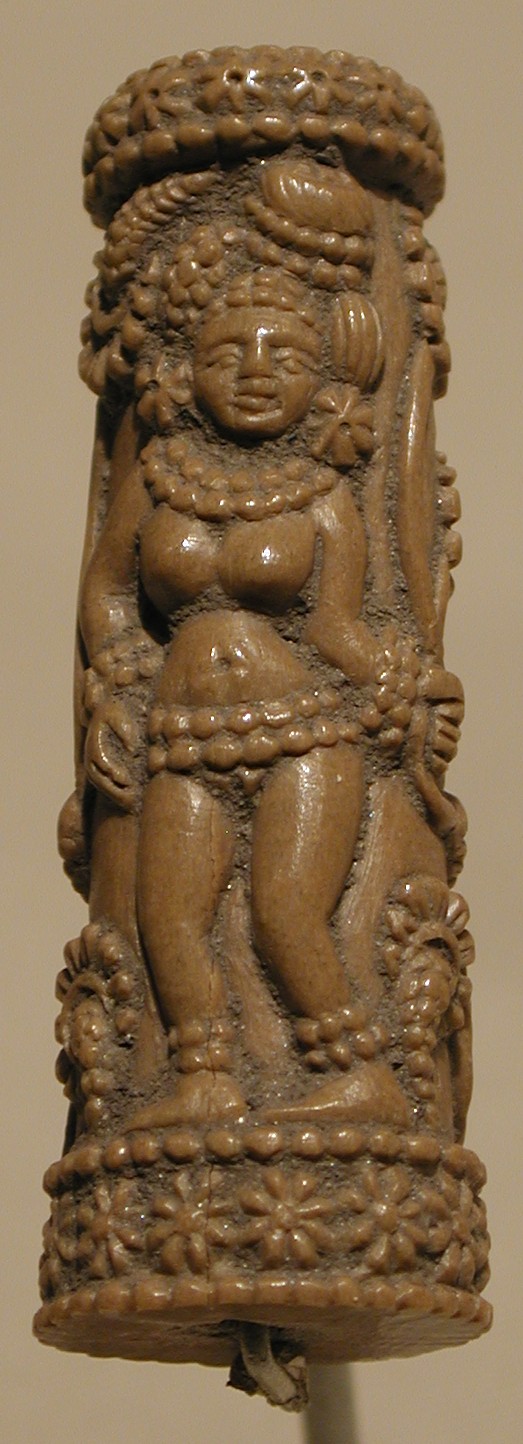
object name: mirror handle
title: Mirror Handle with Two Yakshis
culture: india, bengal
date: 100-1 BCE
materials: ivory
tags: women